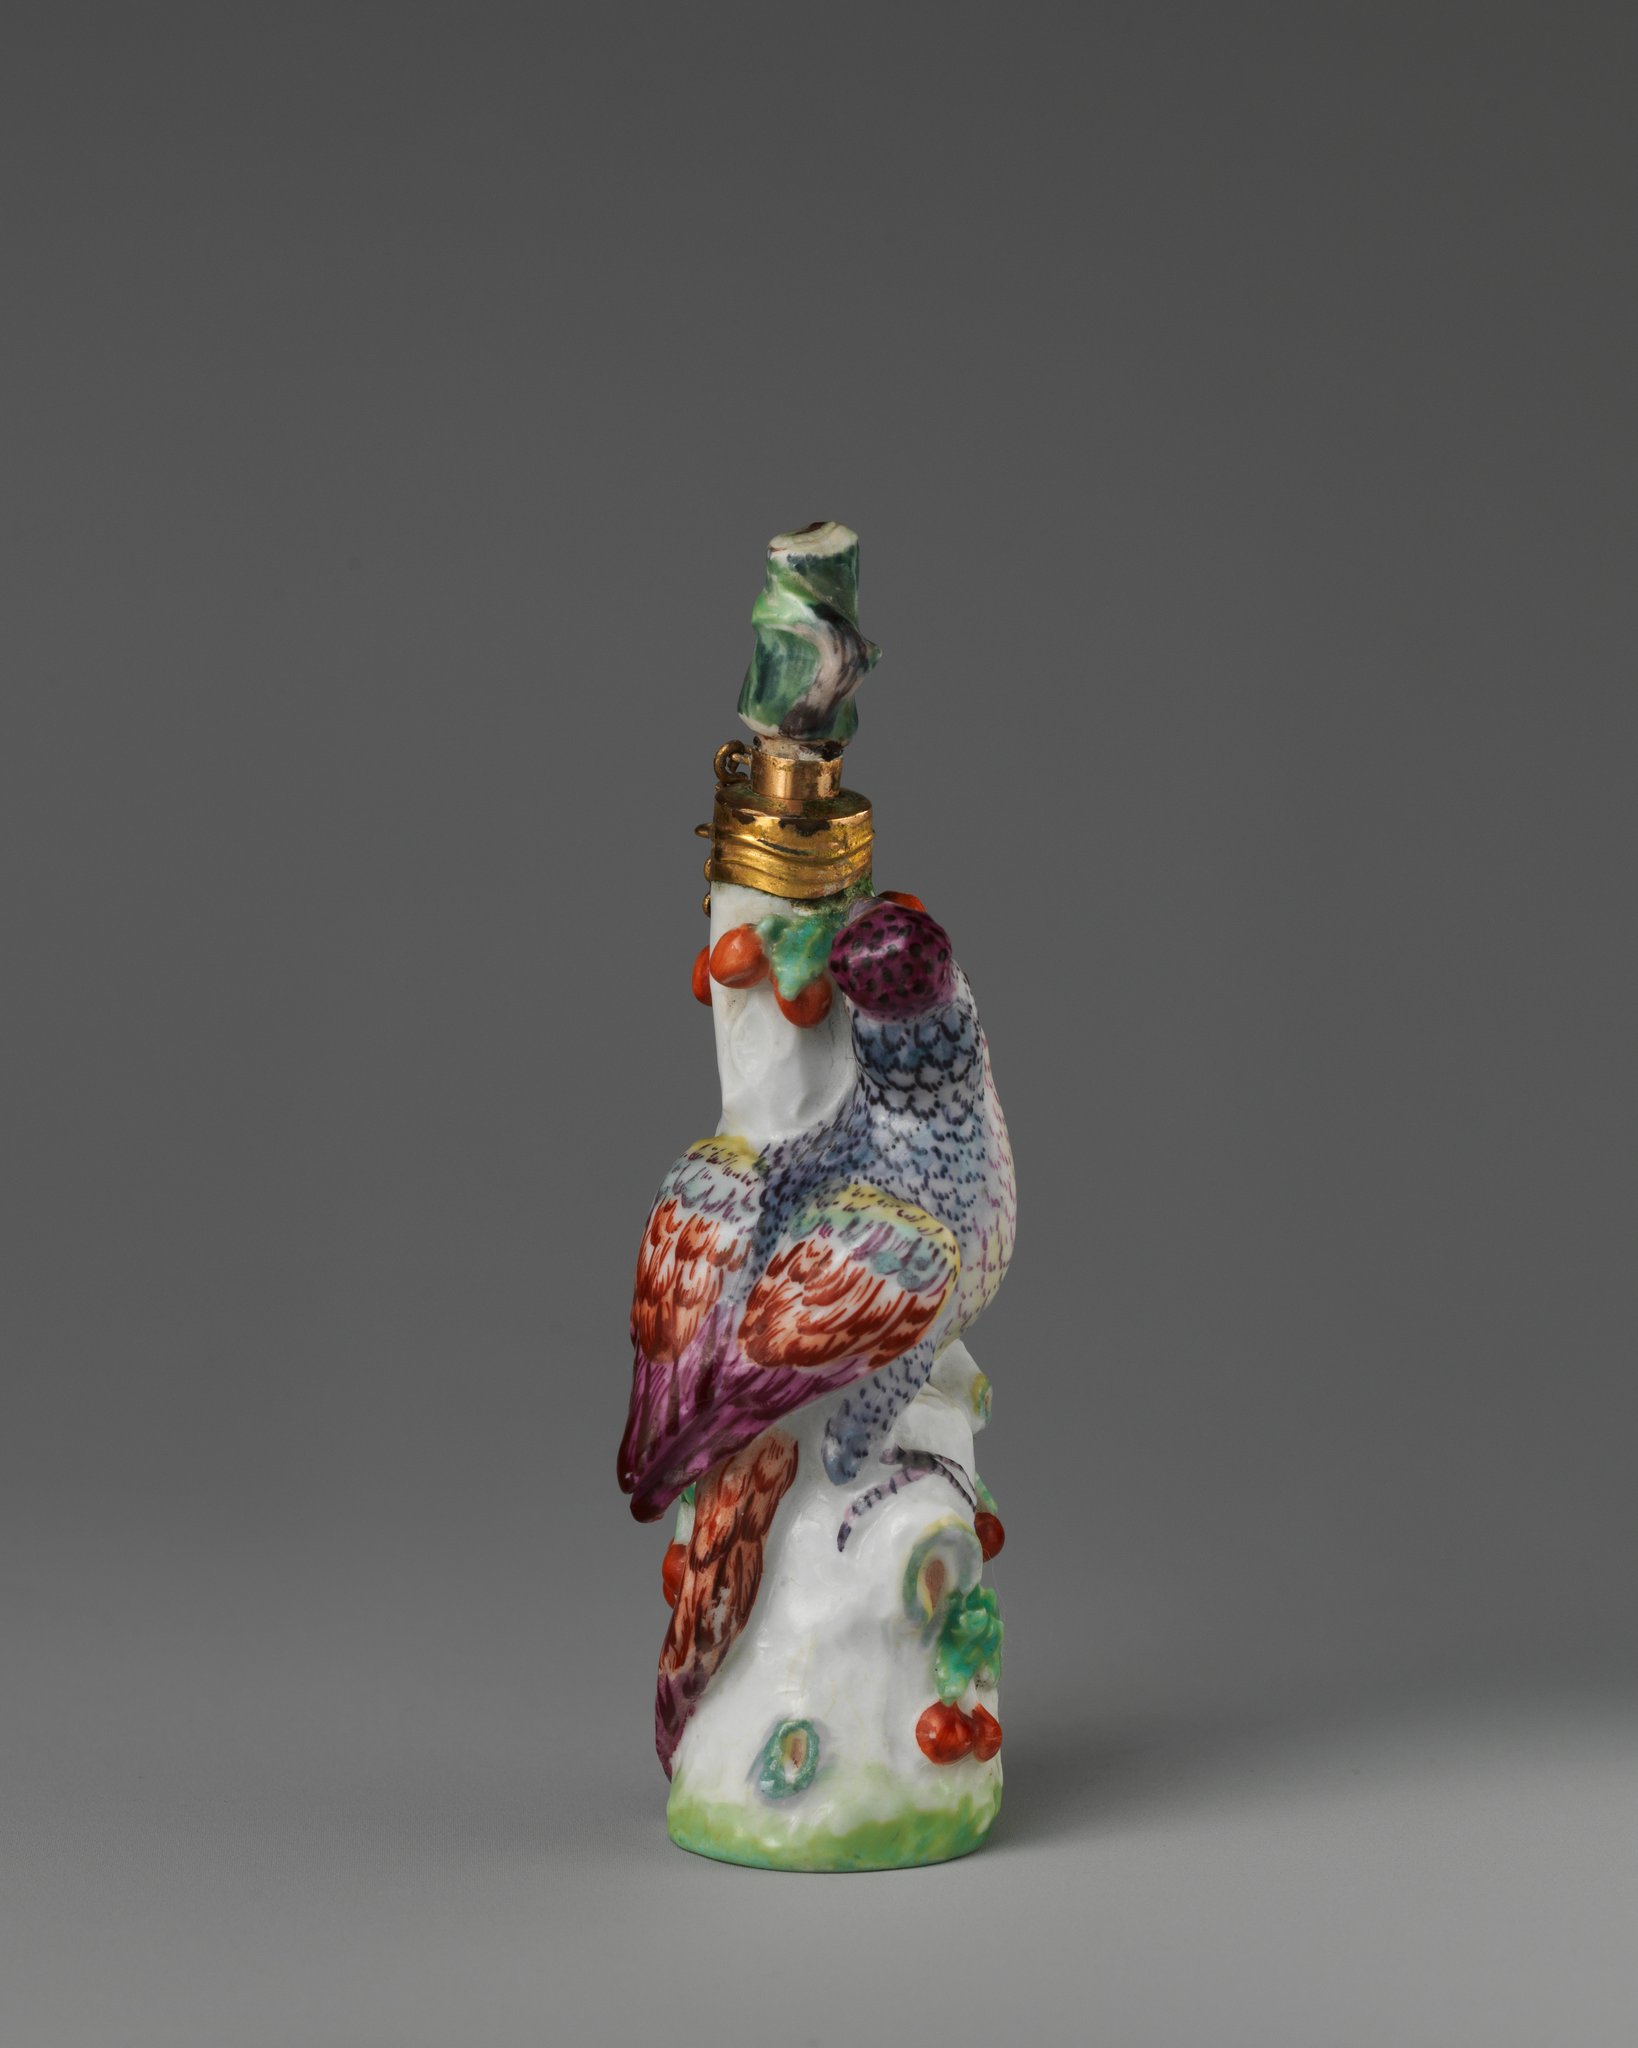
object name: toy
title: Parrot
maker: chelsea porcelain manufactory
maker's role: factory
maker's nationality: british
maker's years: 1744-1784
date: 1759-1769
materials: soft paste porcelain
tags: parrots